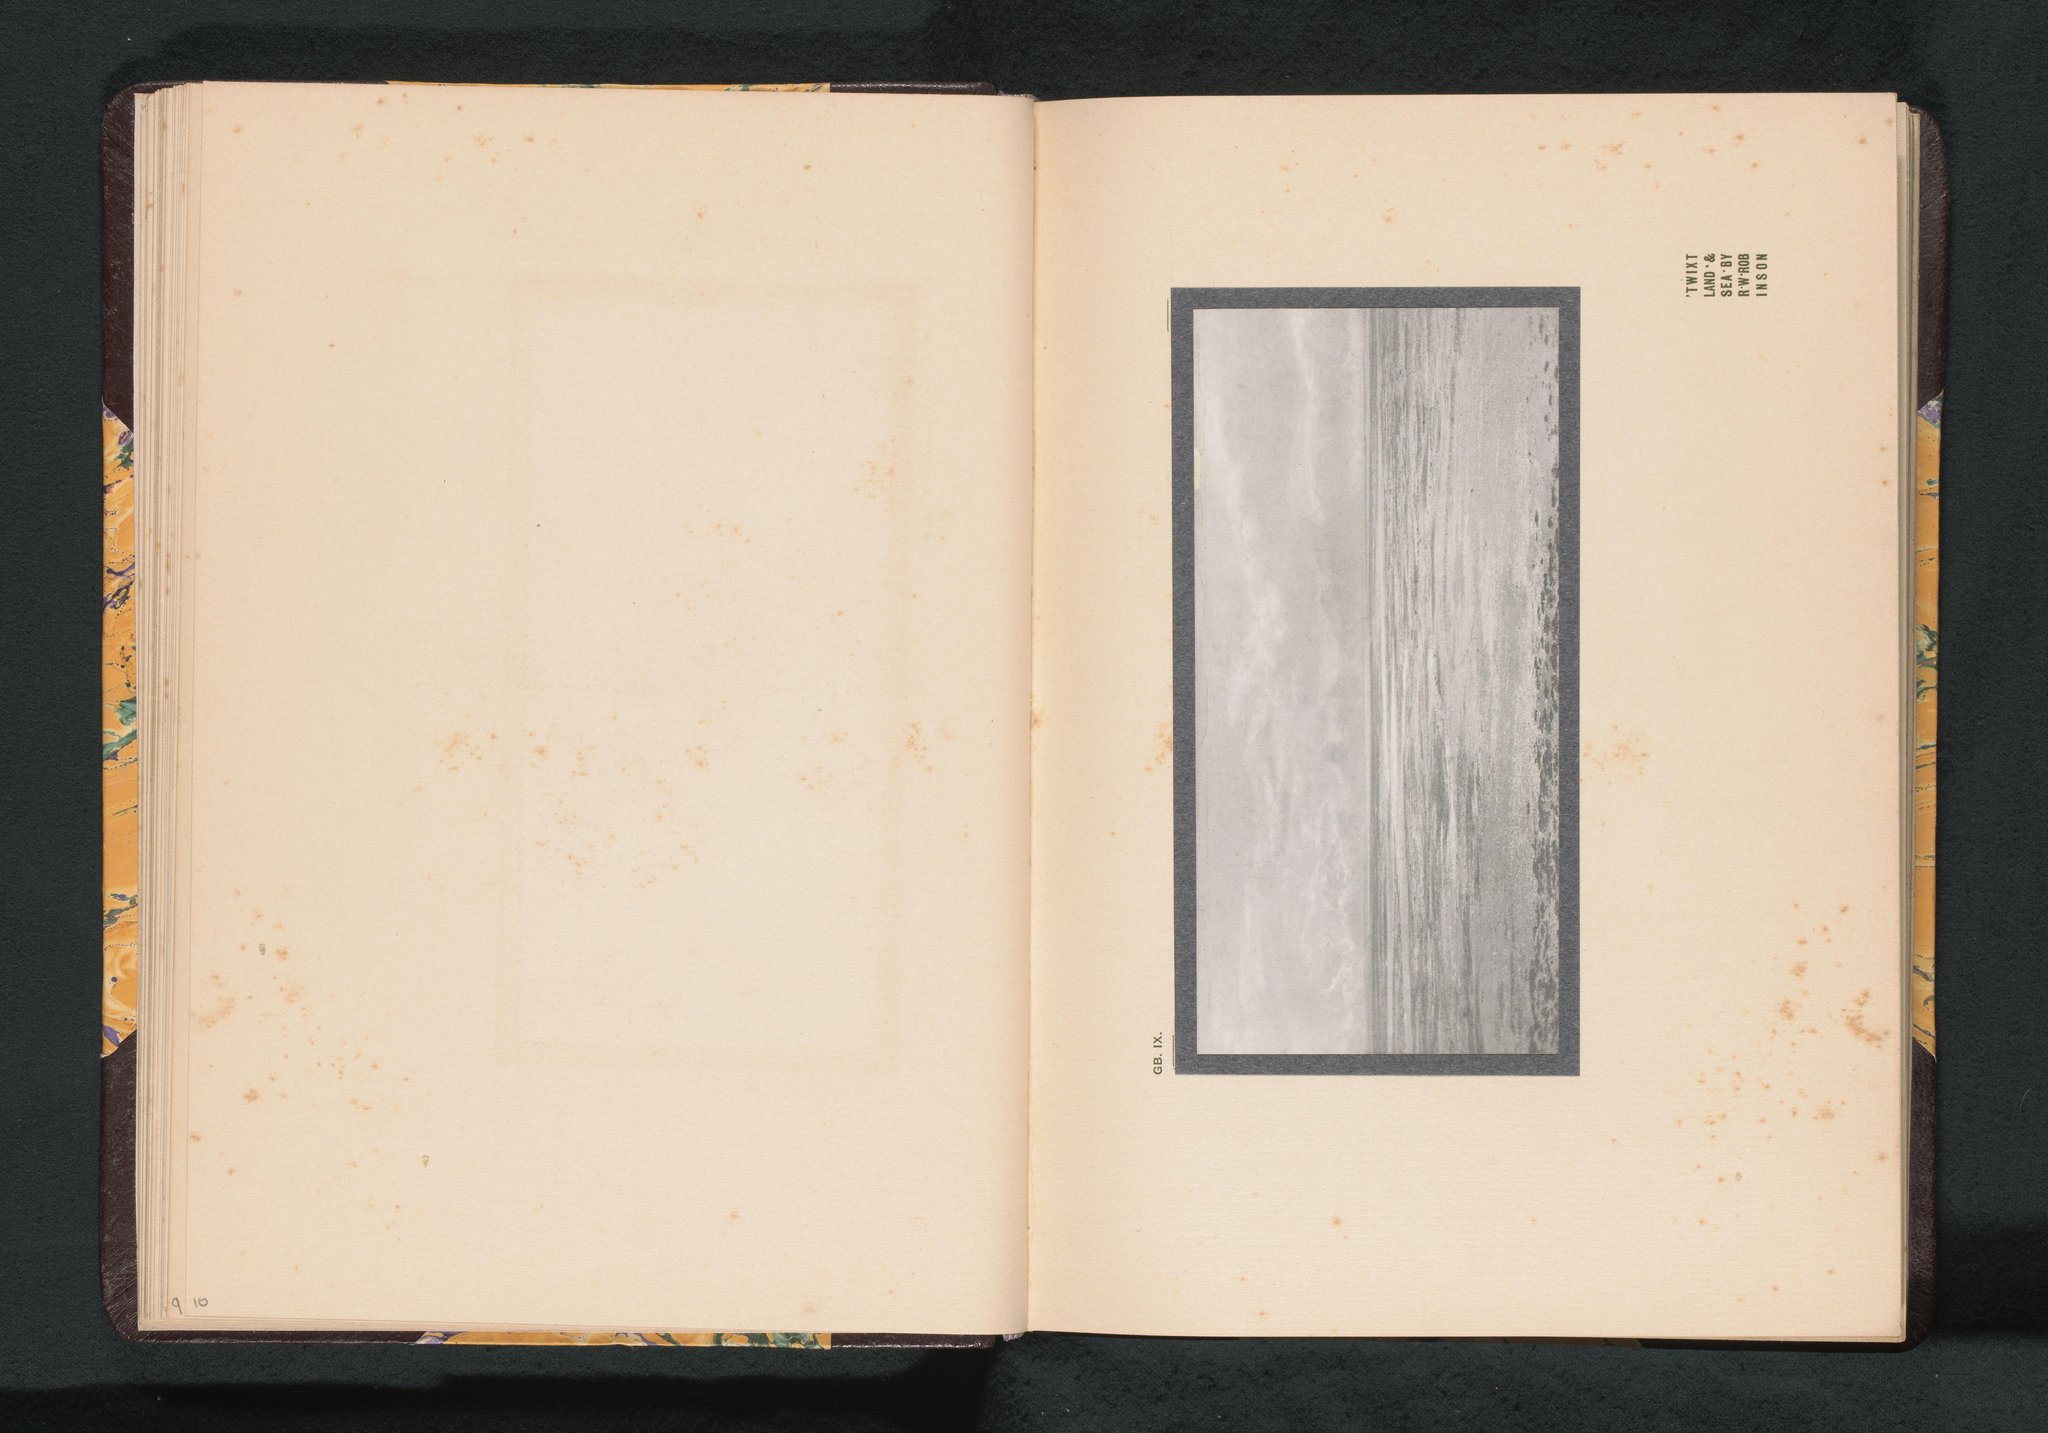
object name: photomechanical print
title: Zeegezicht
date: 1900-1905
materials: paper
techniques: autotype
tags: sea (seascape)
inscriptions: inscription: ‘GB. IX.’, inscription: ‘'Twixt land & sea by R.W. Robinson’